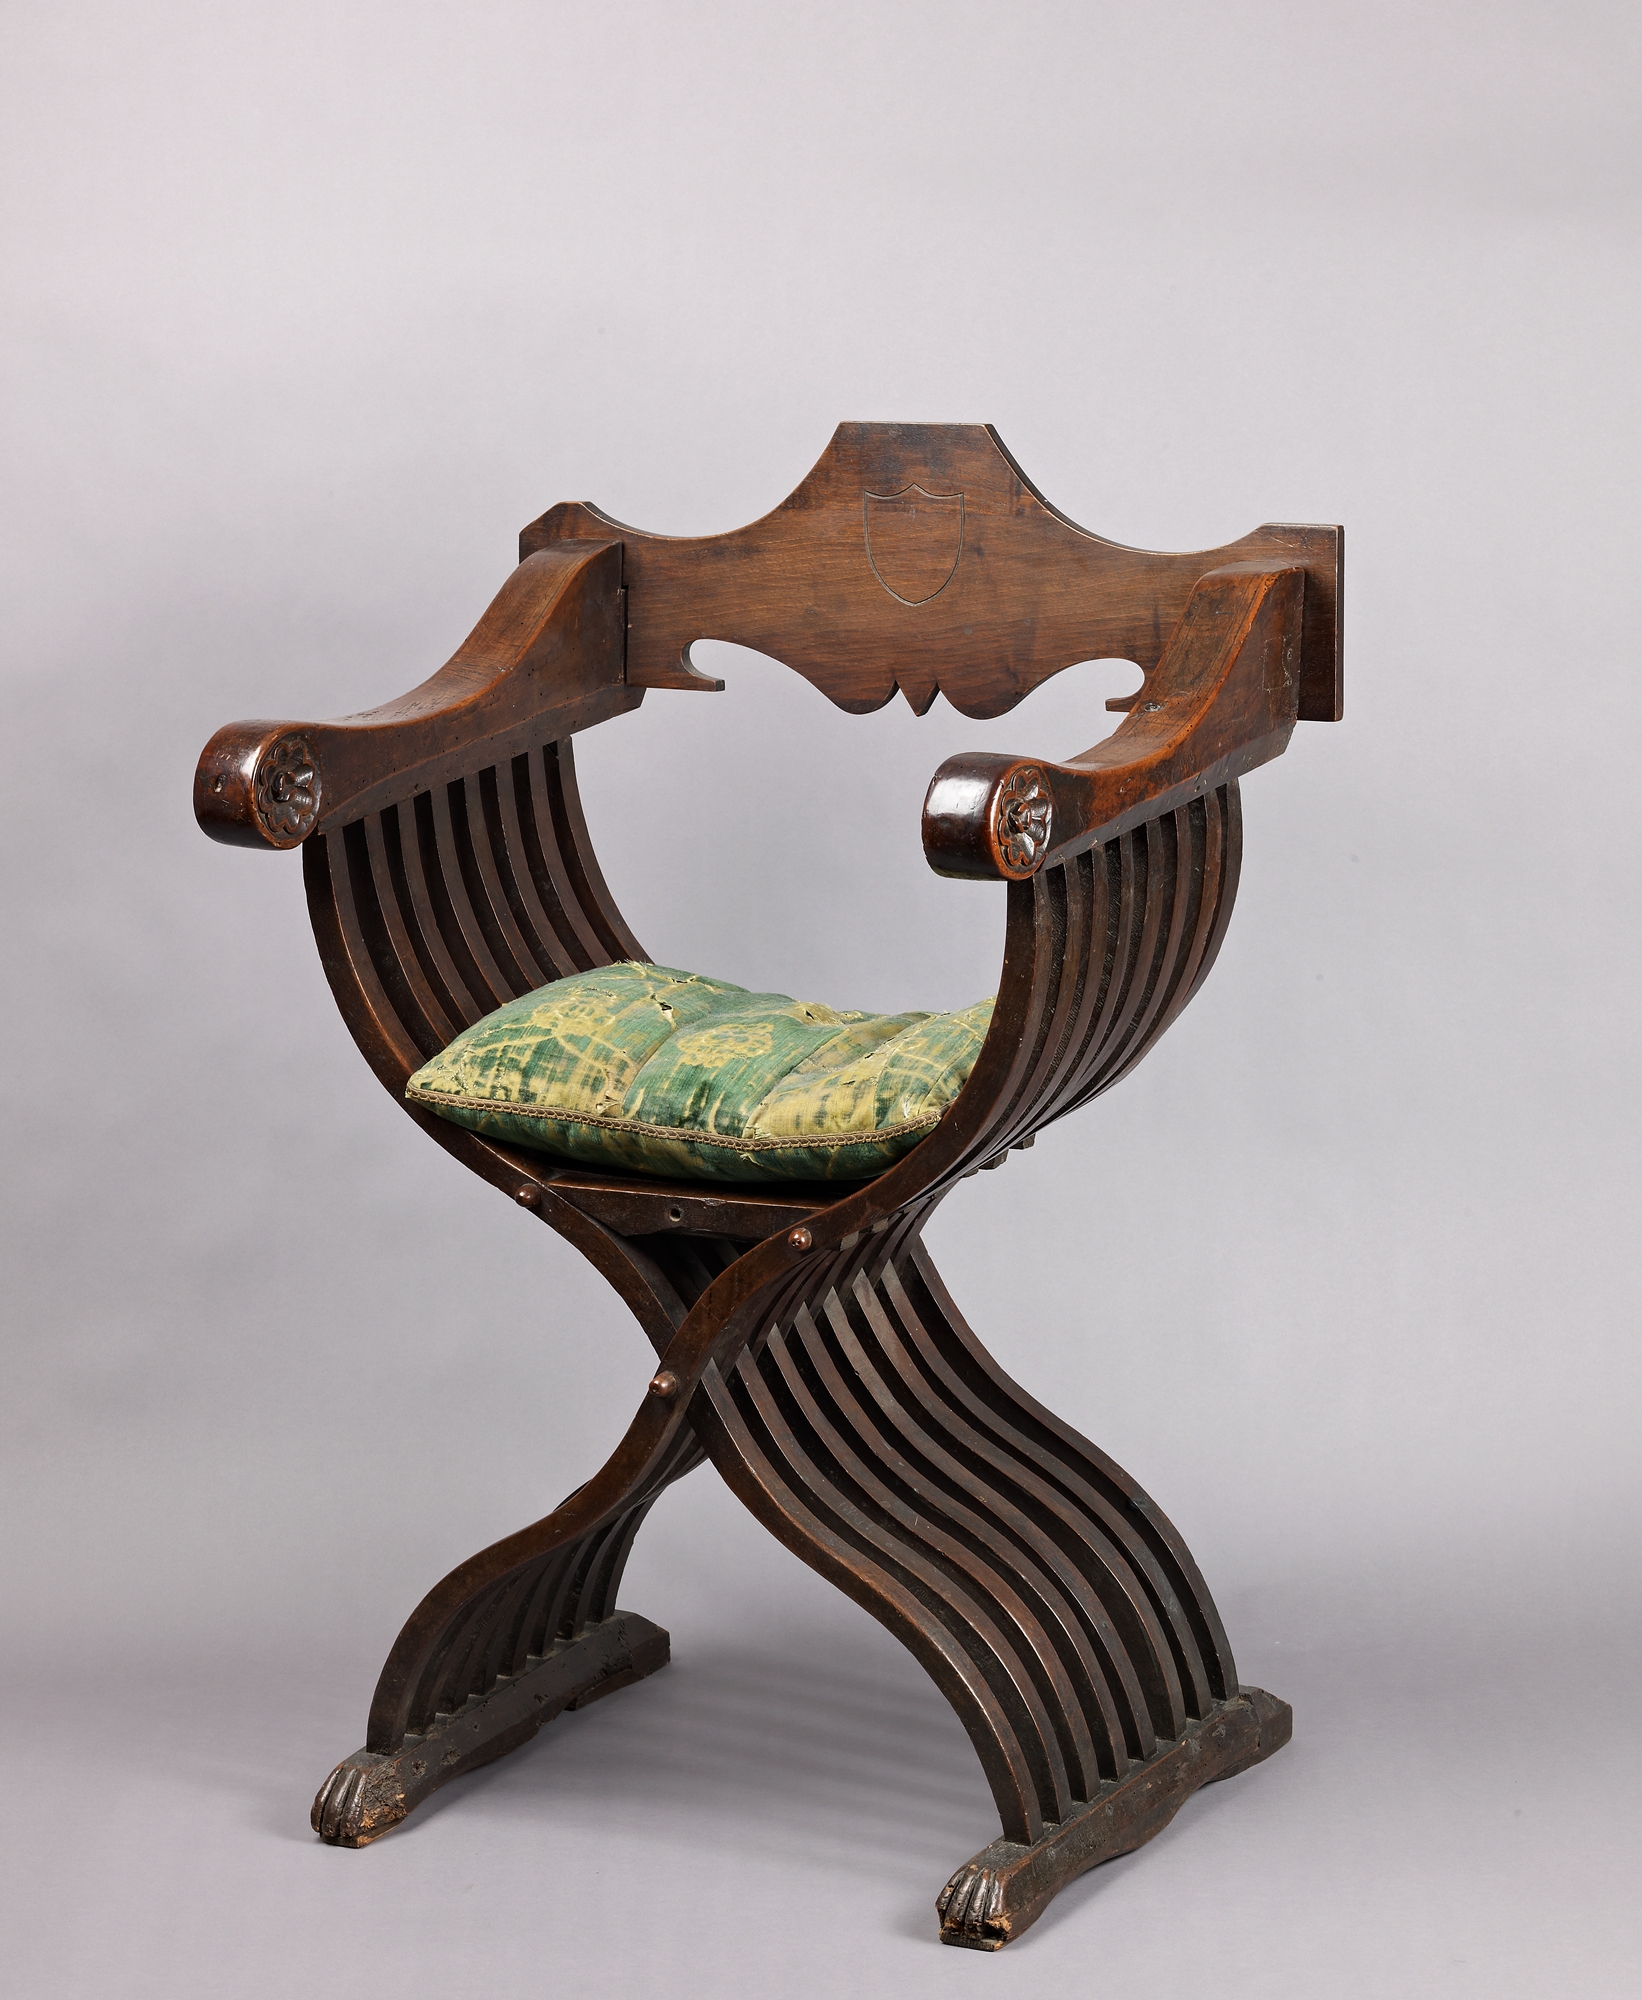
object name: armchair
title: Folding armchair (sedia a Savonarola type)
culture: italian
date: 1401-1500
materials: velvet, wood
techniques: carving